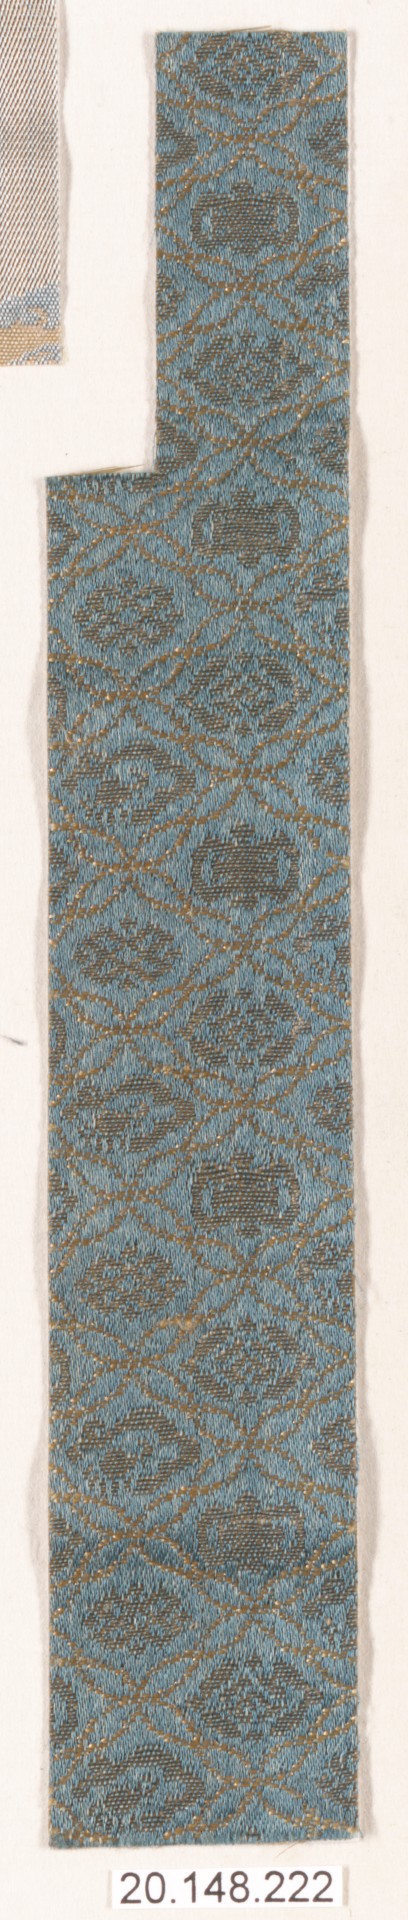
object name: piece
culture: japanese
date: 1701-1800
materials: silk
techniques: compound weave